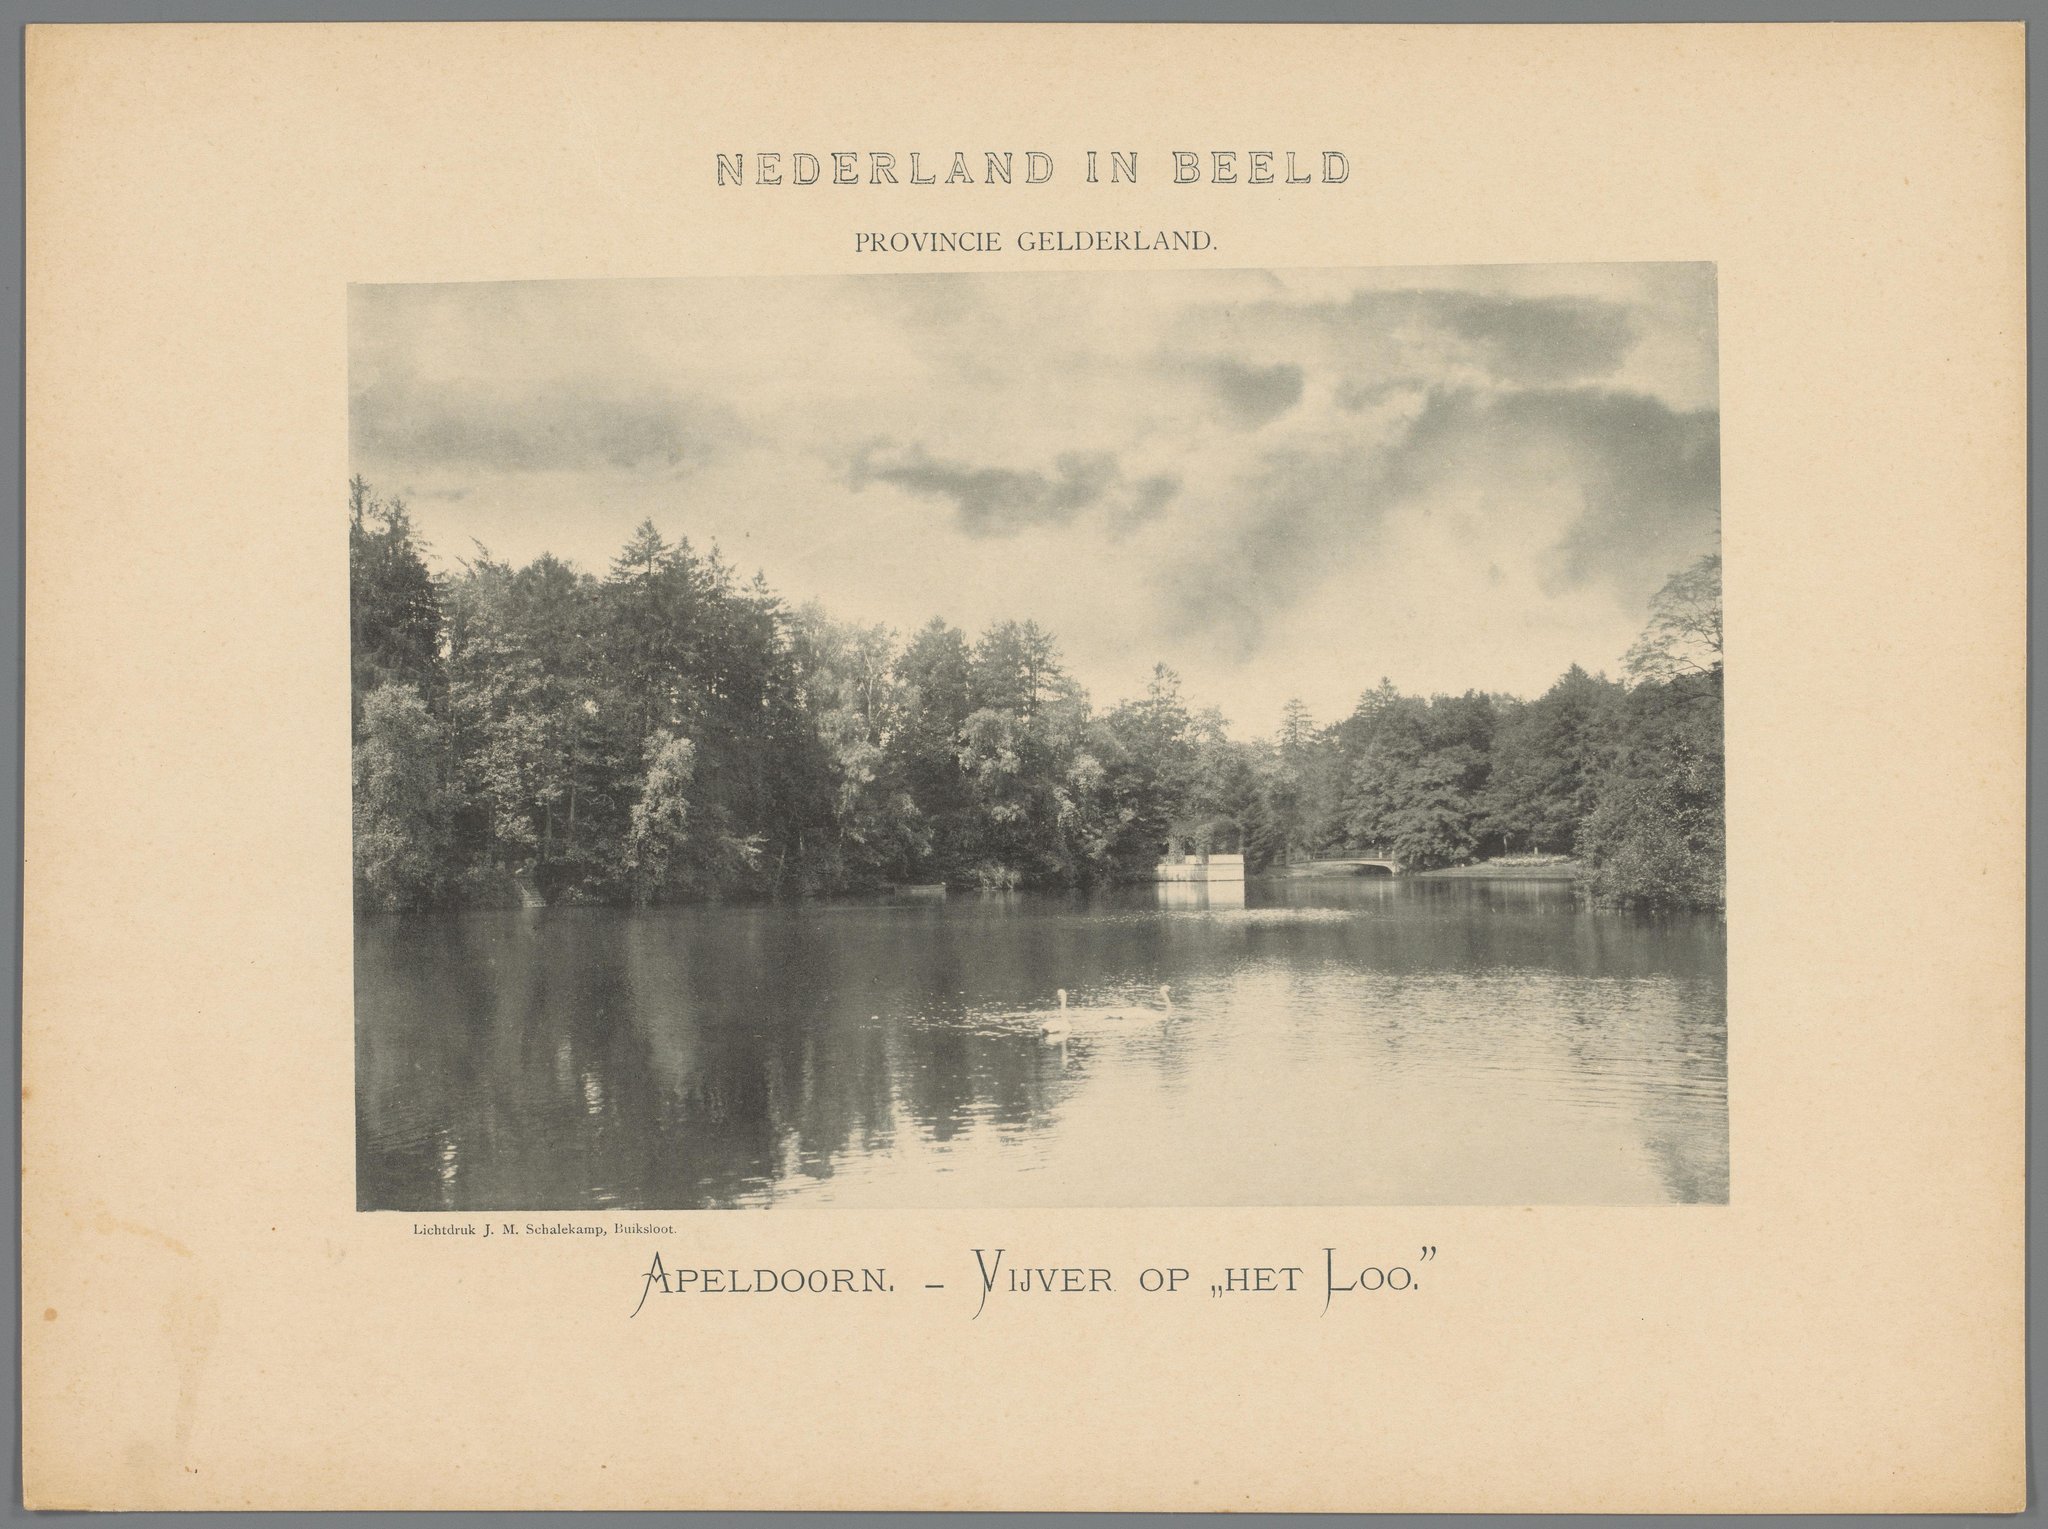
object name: photomechanical print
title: Nederland in beeld. Provincie Gelderland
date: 1893-1897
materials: paper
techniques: photograph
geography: buiksloot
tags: garden pond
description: Deze prent maakt deel uit van een omslag met 43 lichtdrukken op 43 bladen.